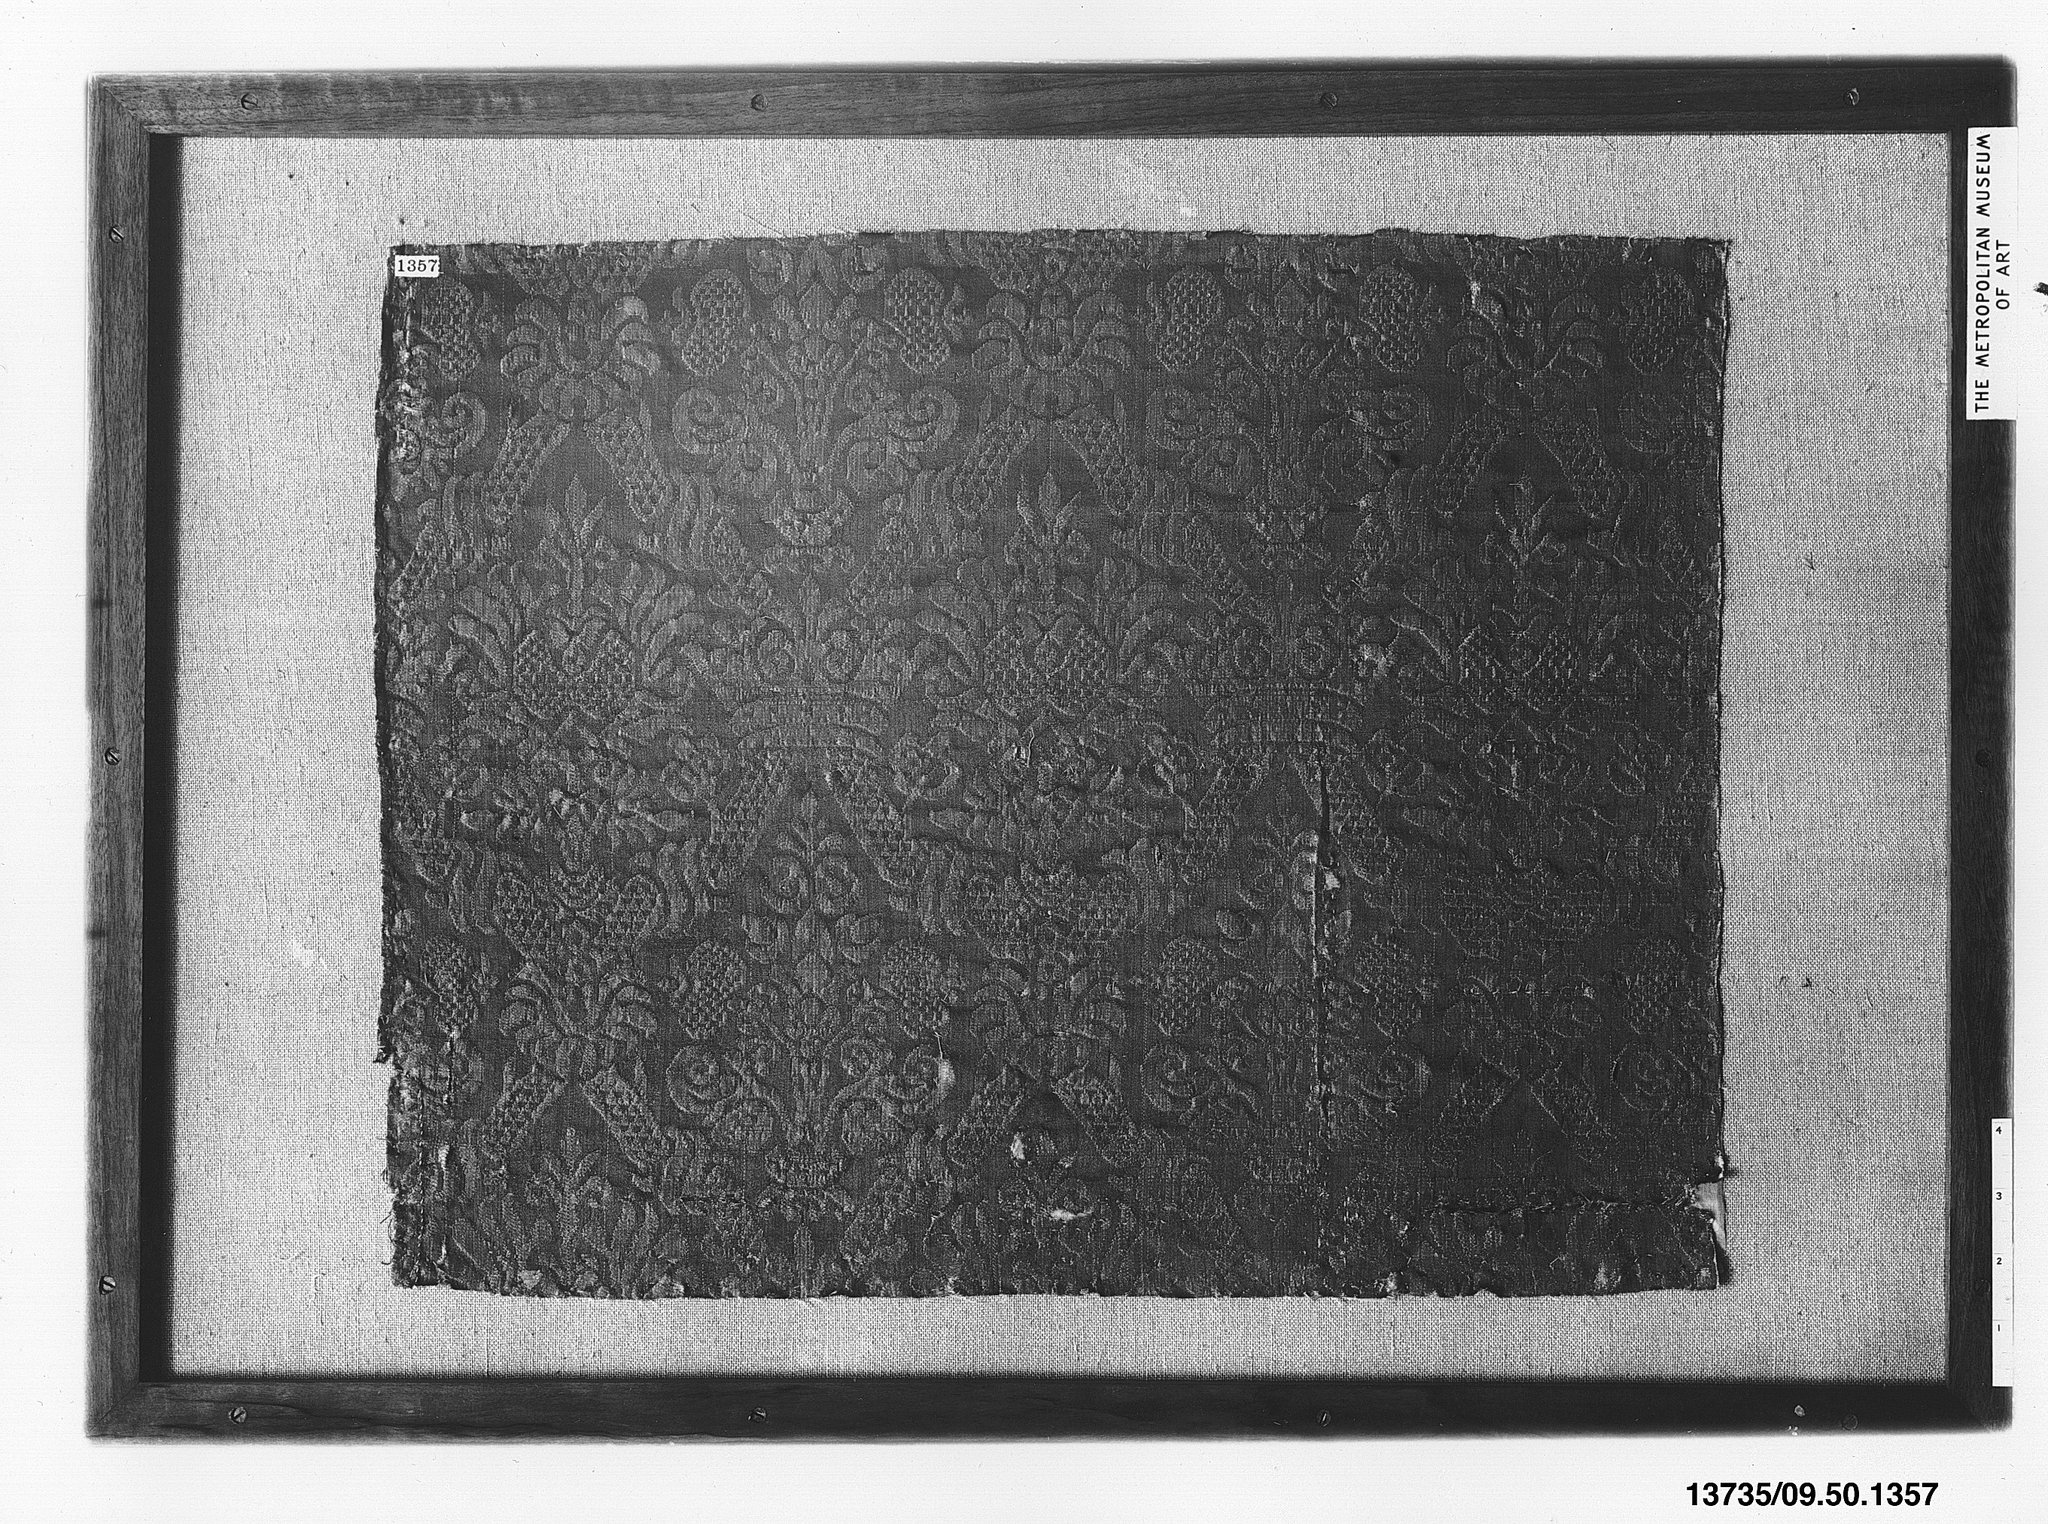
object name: piece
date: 1501-1600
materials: silk